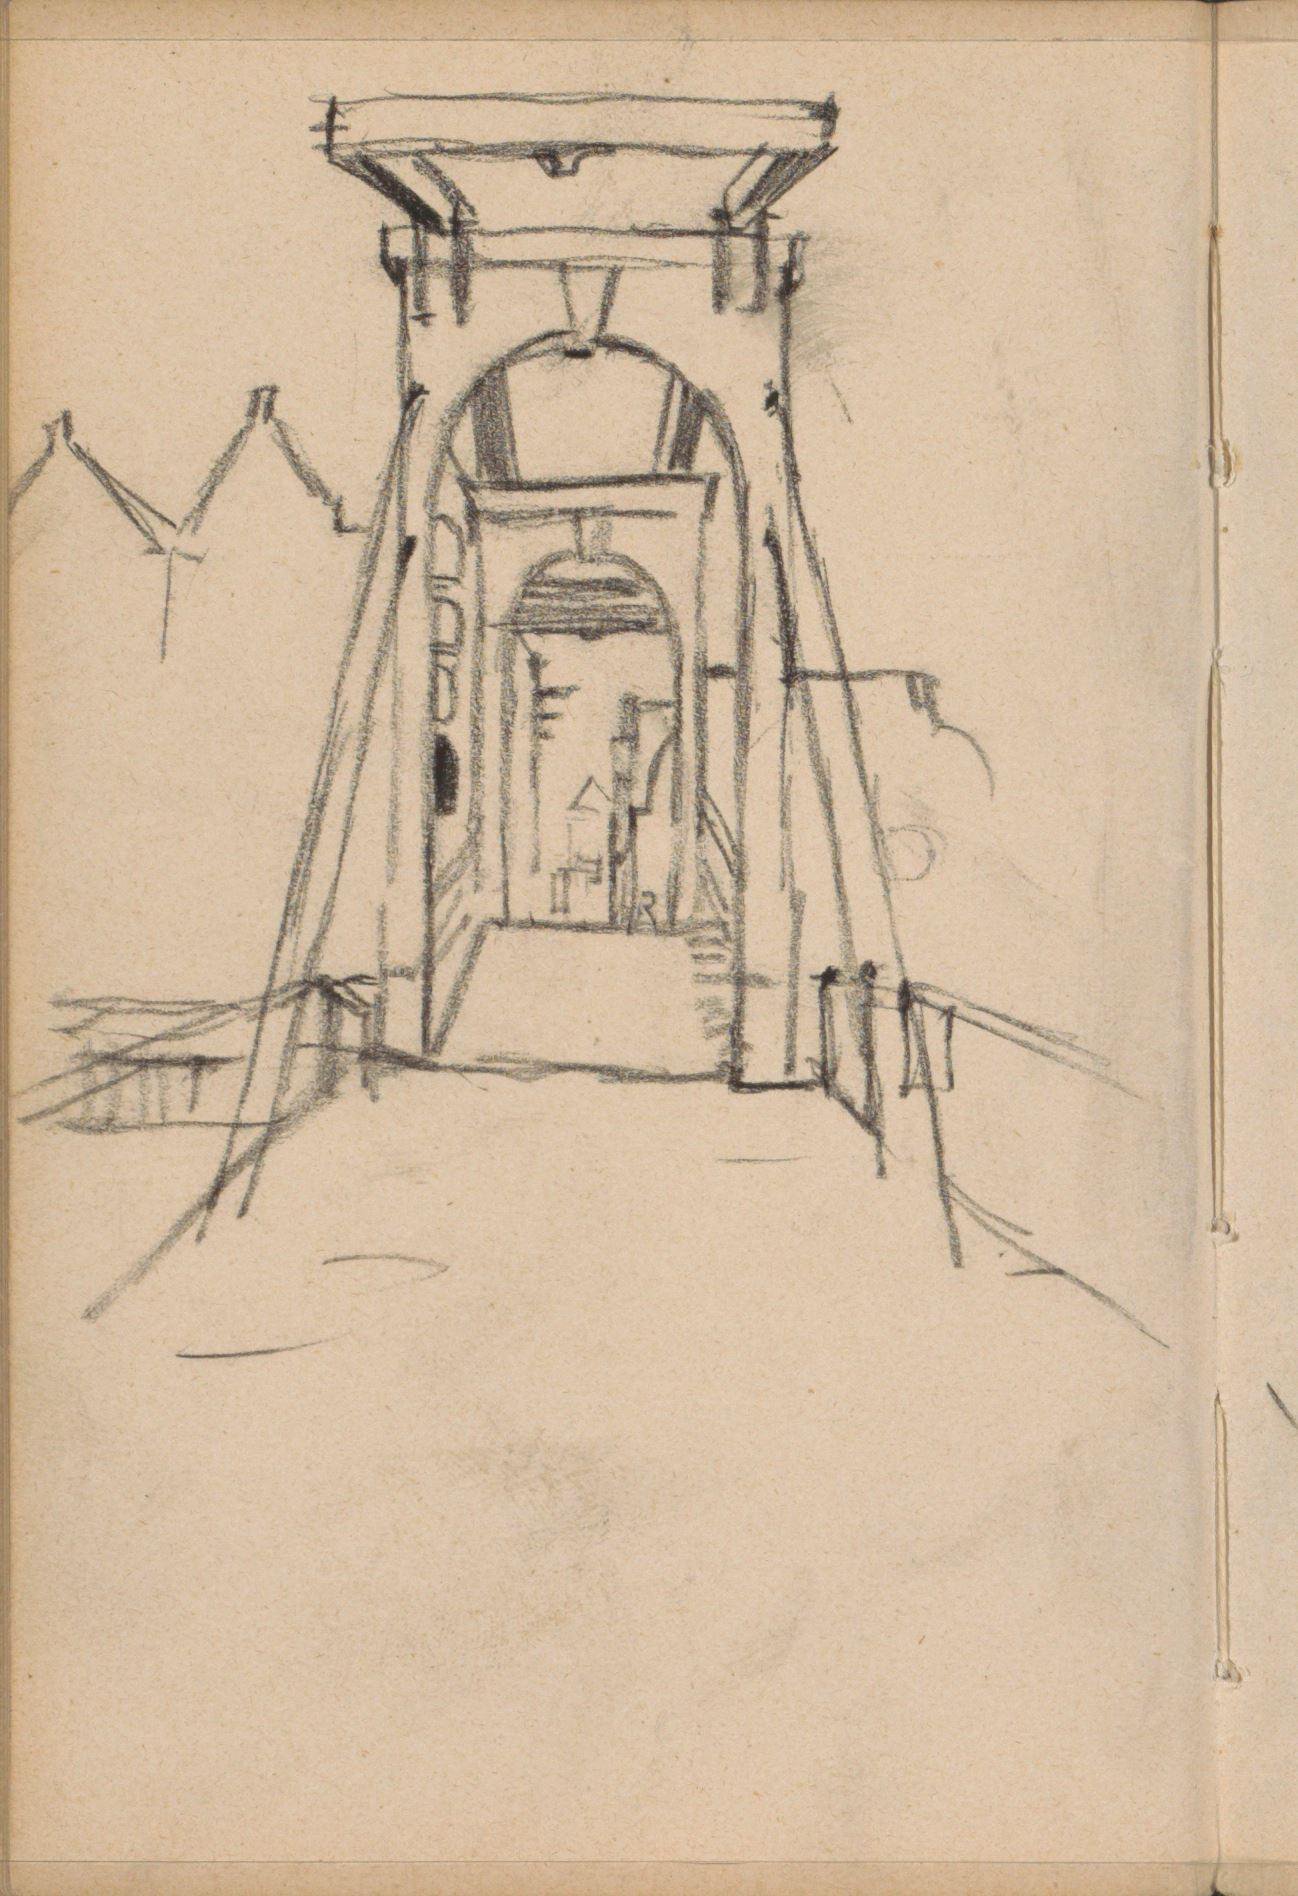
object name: sketchbook leaf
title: Gezicht op de Sloterdijkbrug te Amsterdam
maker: george hendrik breitner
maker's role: draughtsman, painter, print maker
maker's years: 1857-1923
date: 1906-1923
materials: chalk, paper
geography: amsterdam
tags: urban housing, bridge in city across river, canal, etc.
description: Gezicht op de Sloterdijkbrug te Amsterdam. Op de achtergrond Prinseneiland. Pagina 35 uit een schetsboek met 46 bladen vervaardigd in Amsterdam en Haarlem.